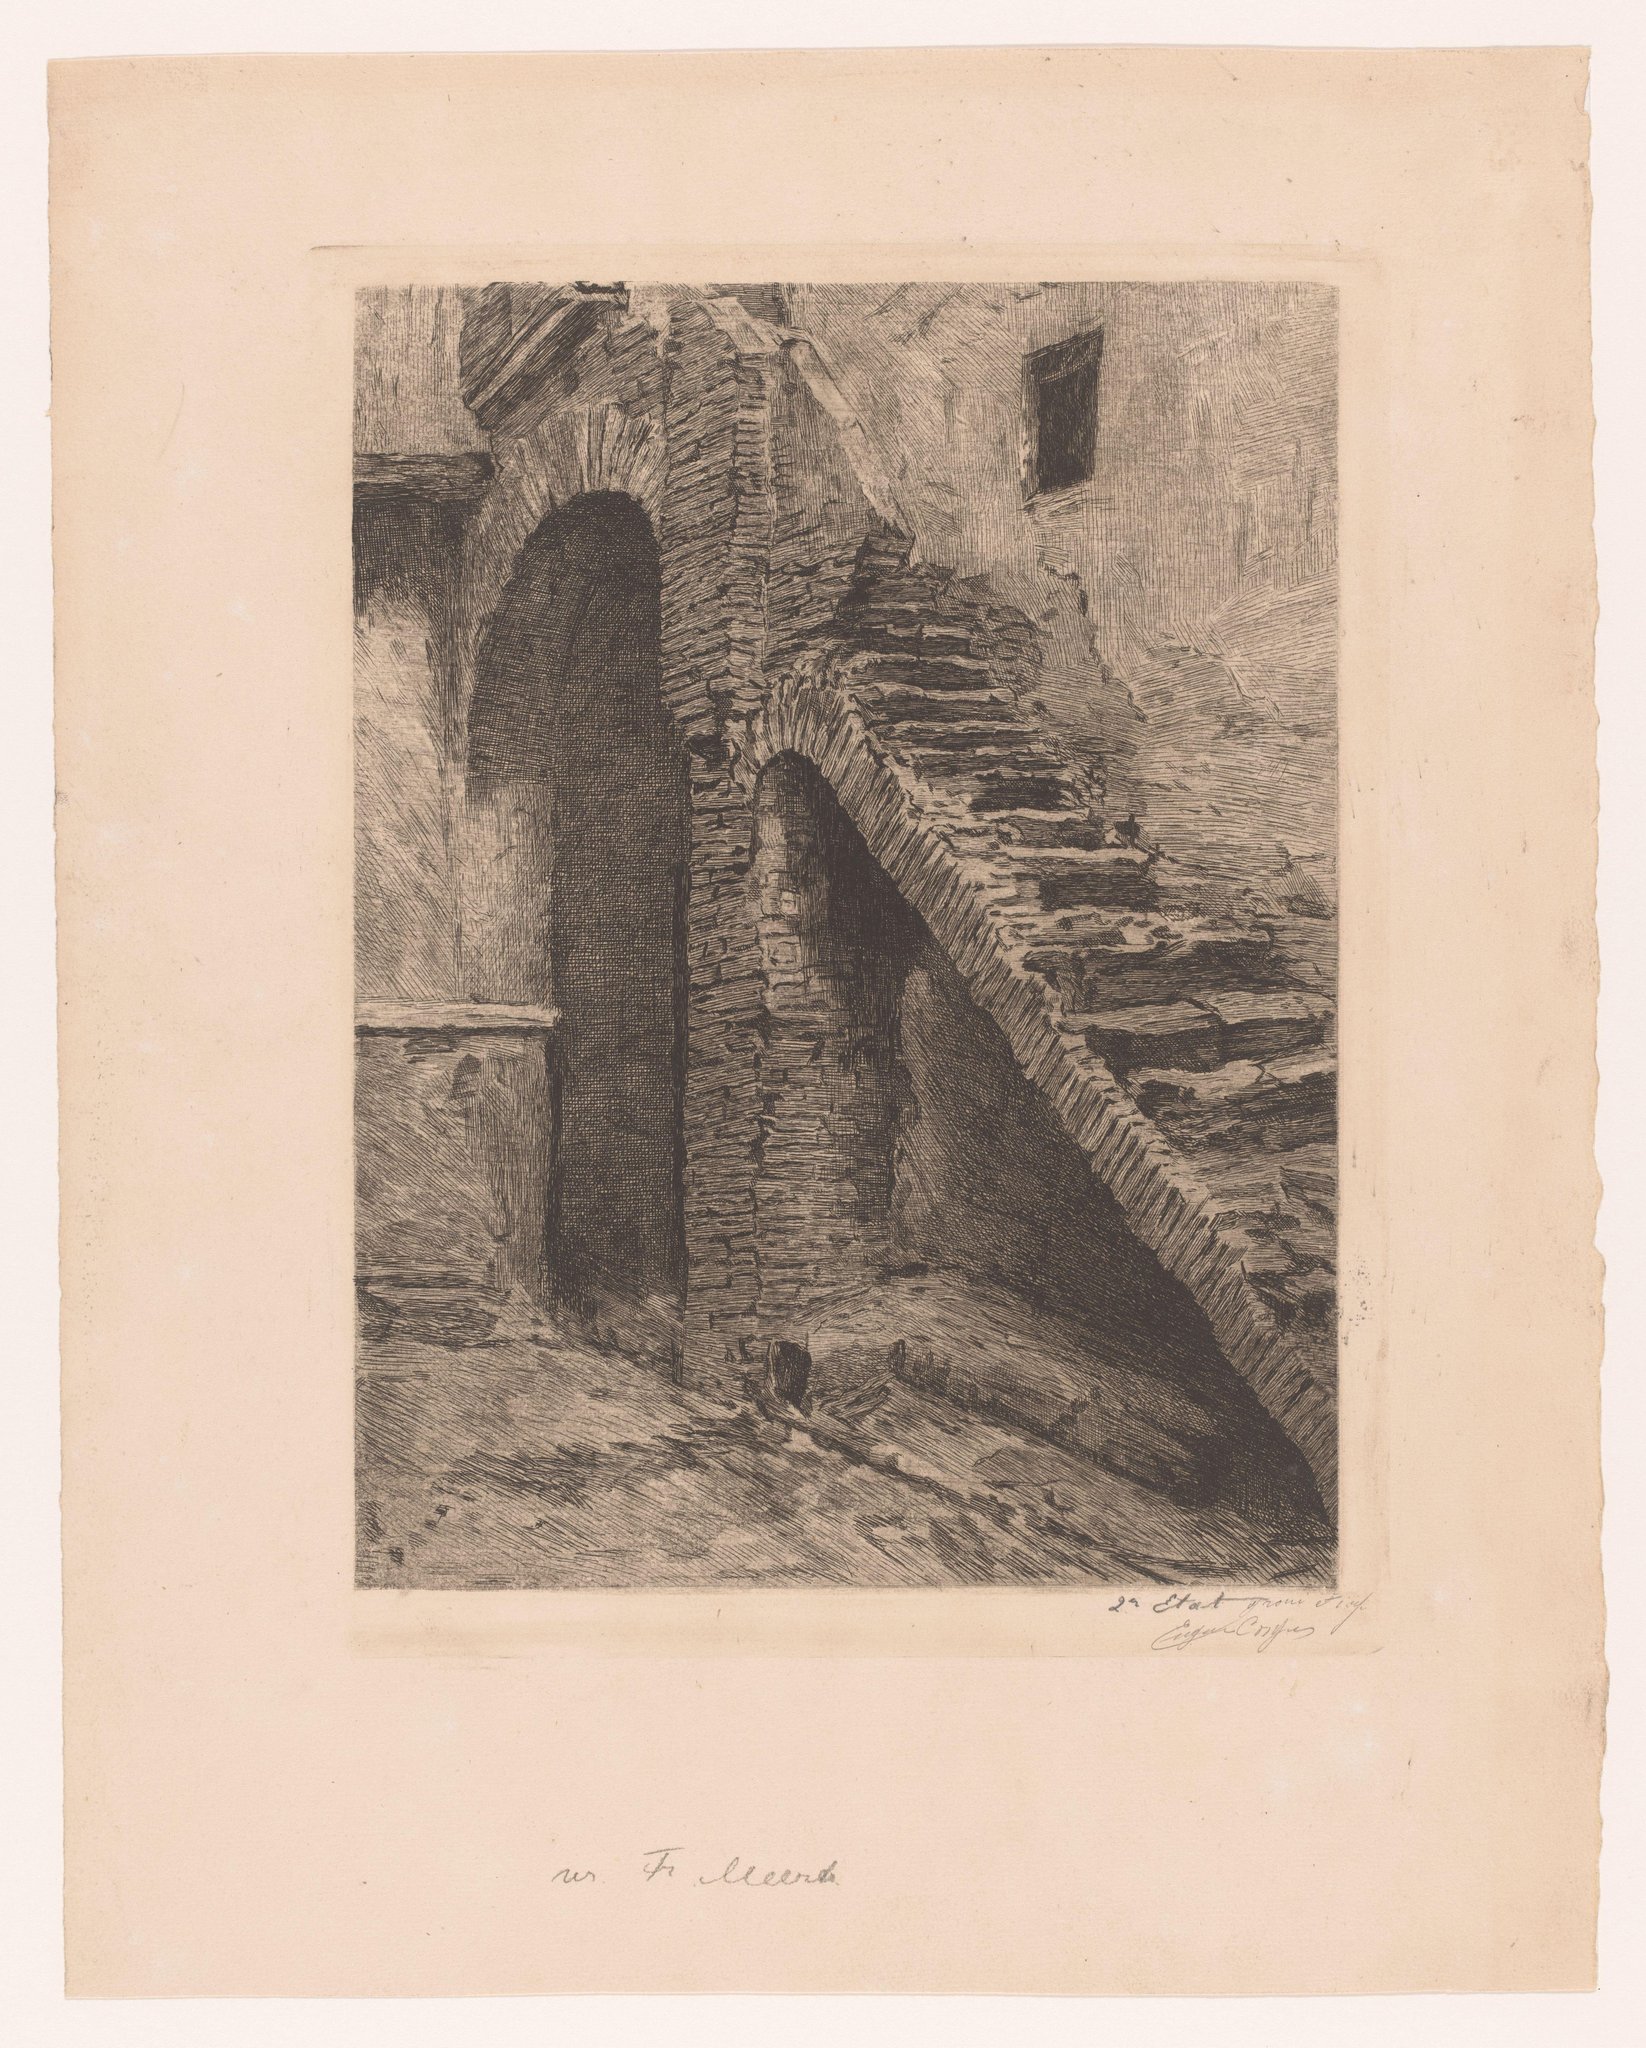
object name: print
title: Vervallen trap van terzijde gezien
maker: eugène cosyns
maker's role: print maker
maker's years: 1862-1909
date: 1872-1909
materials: paper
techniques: etching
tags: staircase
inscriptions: collector's mark: Lugt 2228, inscription: ‘2e Etat grave [...]’